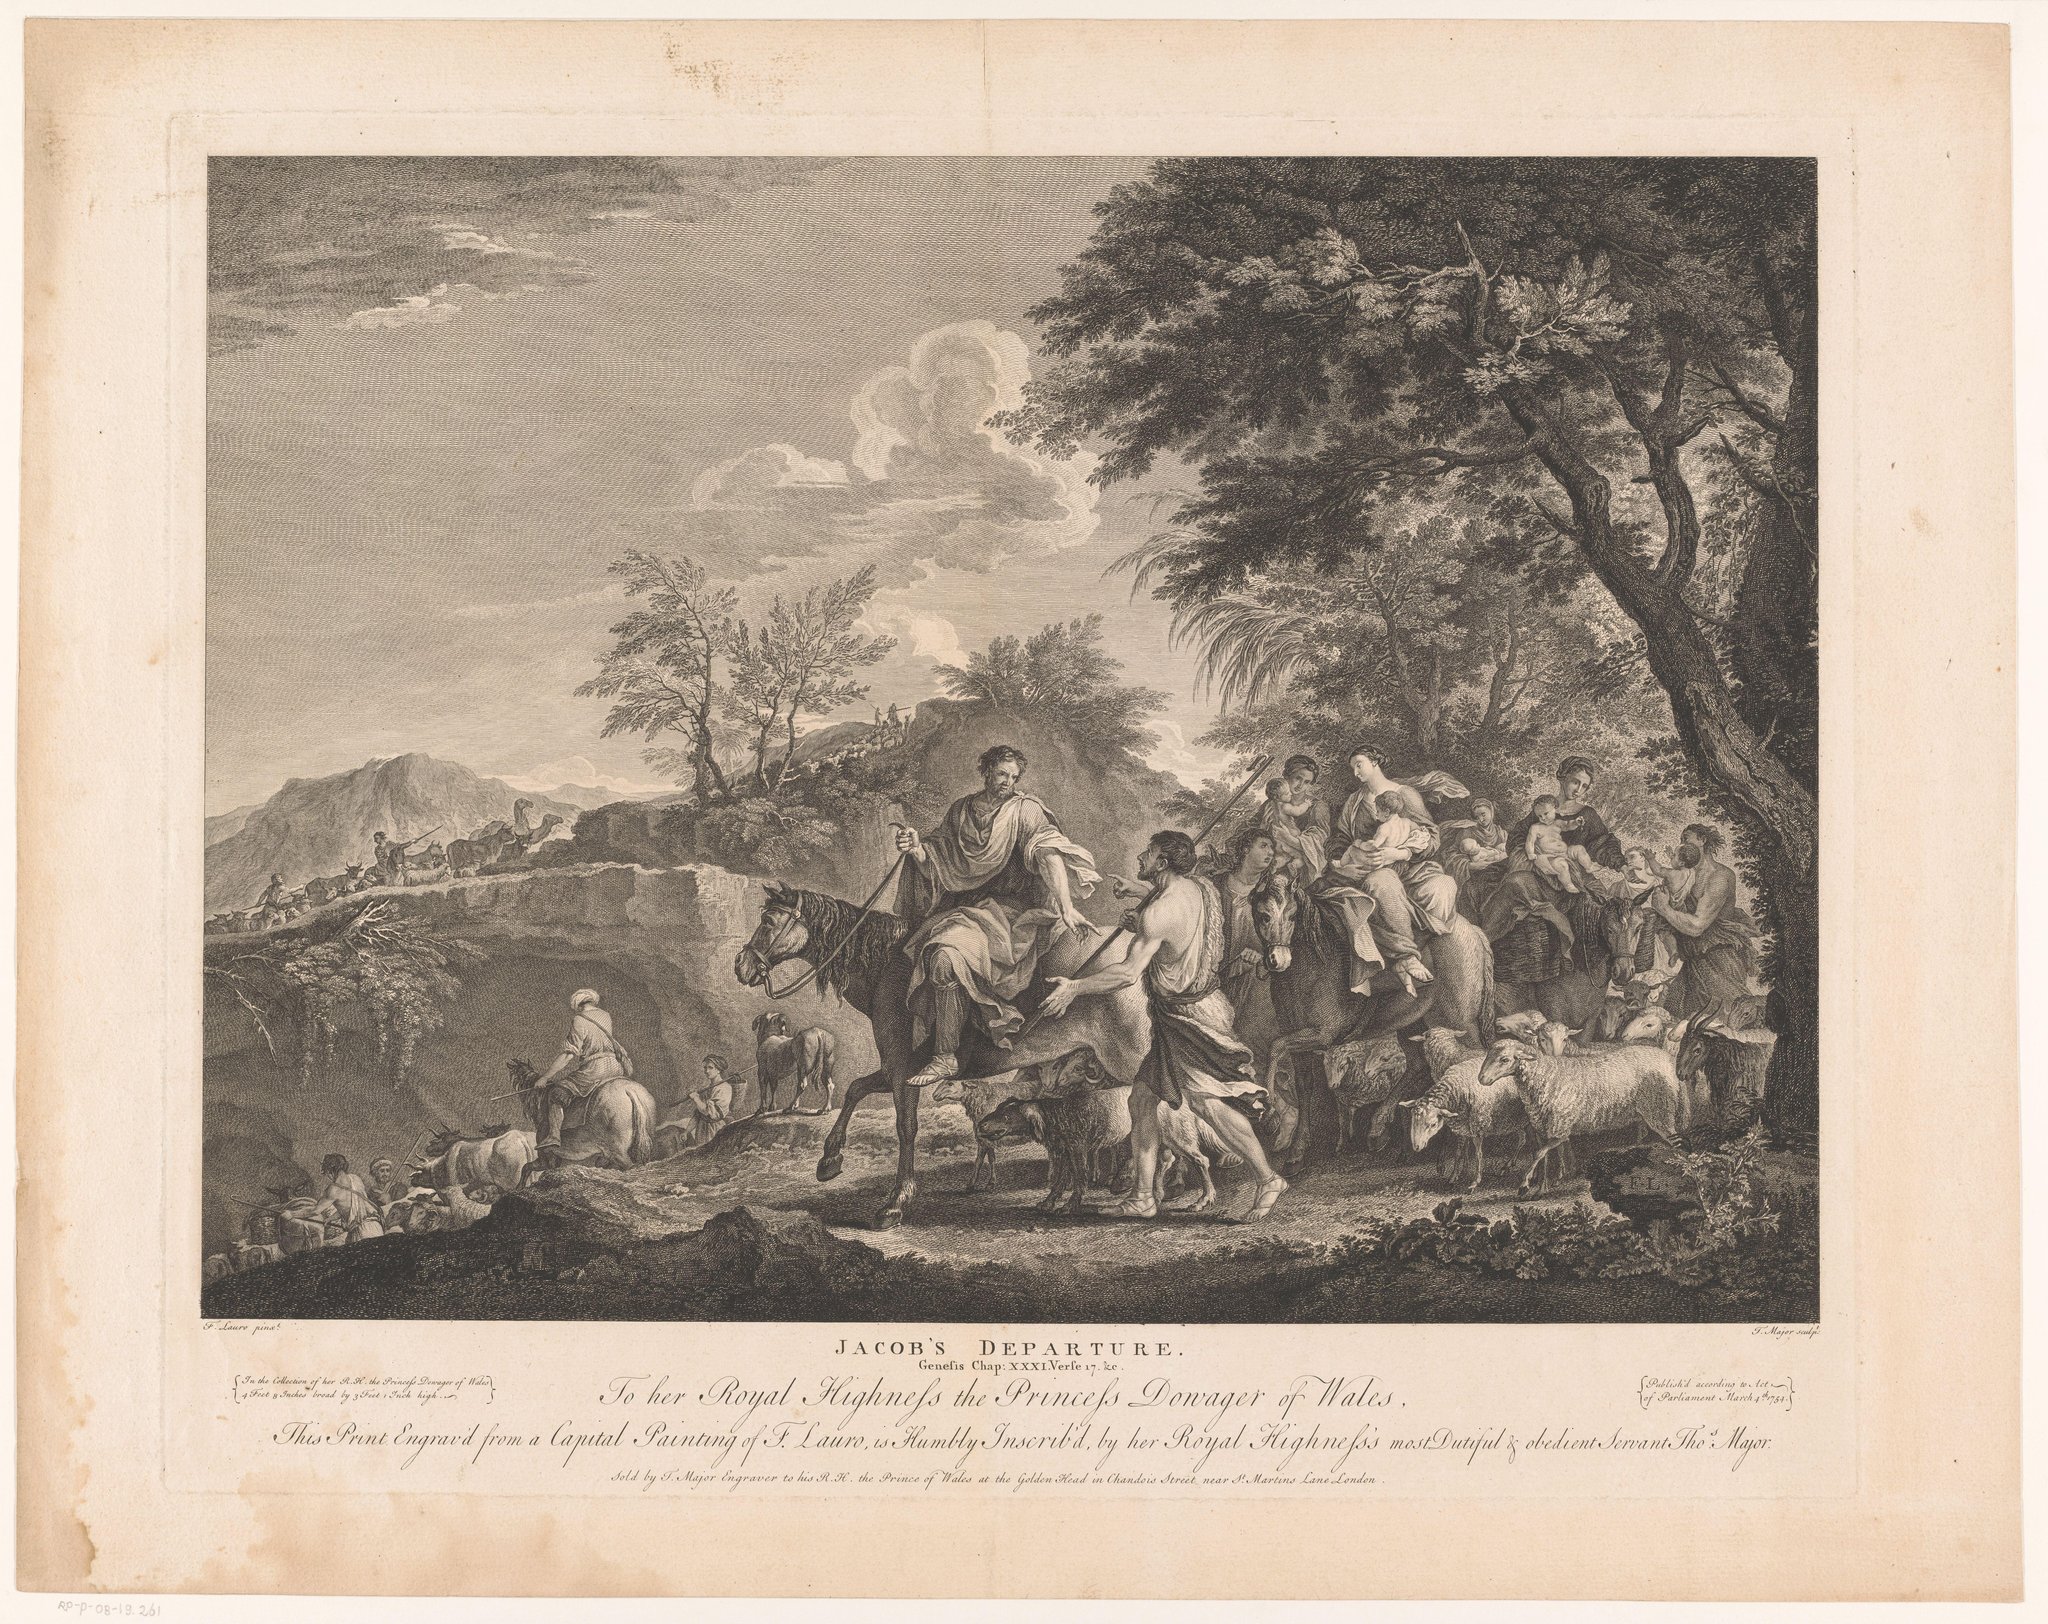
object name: print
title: Jacobs vertrek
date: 1754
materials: paper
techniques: engraving, etching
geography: london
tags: joseph's departure (after being sold by his brothers)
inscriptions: collector's mark: Lugt 2228